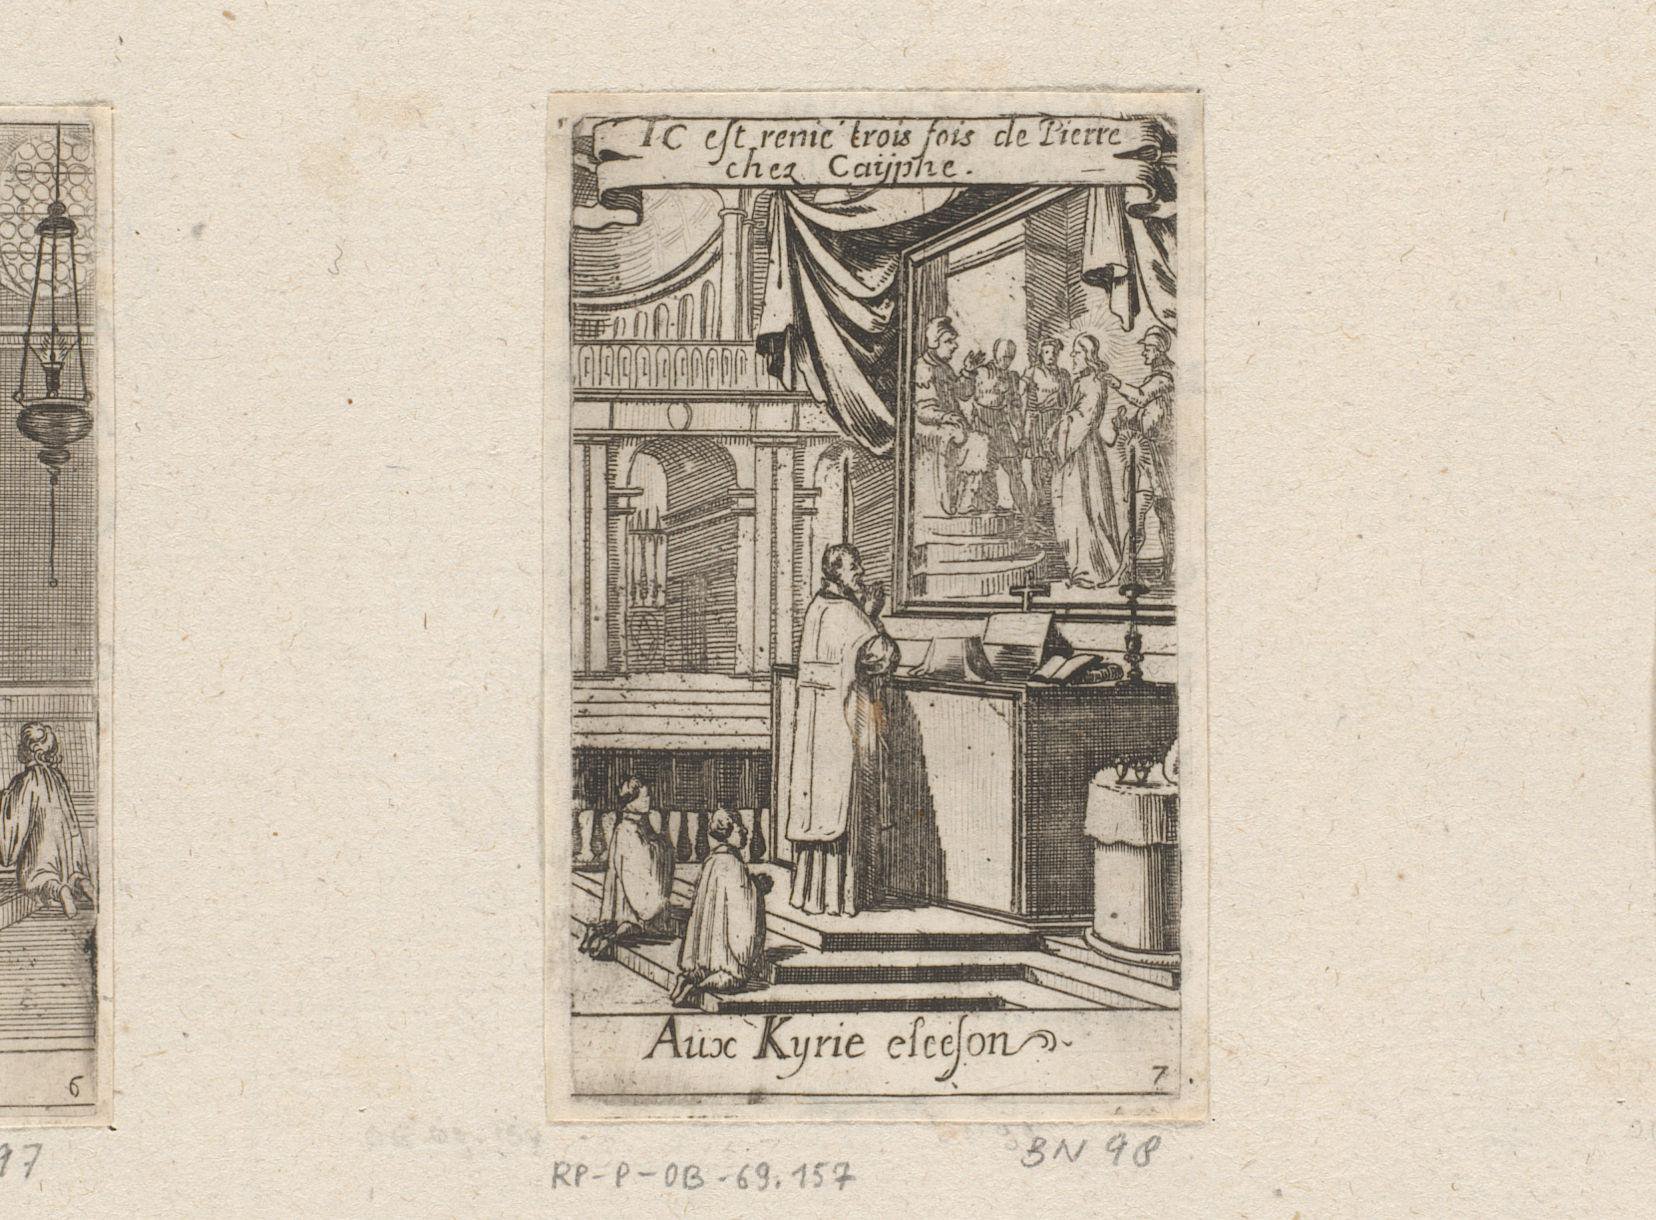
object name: book illustration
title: Aux Kyrie eleeson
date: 1661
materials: paper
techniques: etching, letterpress printing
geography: france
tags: priest (roman catholic), altar with altar-piece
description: Prent uit: Mengin, L. Tableaux ou sont representees la passion de N.S. Christ et les actions du prestre a la S. Messe (...). Metz: Claude Bouchard, 1661.